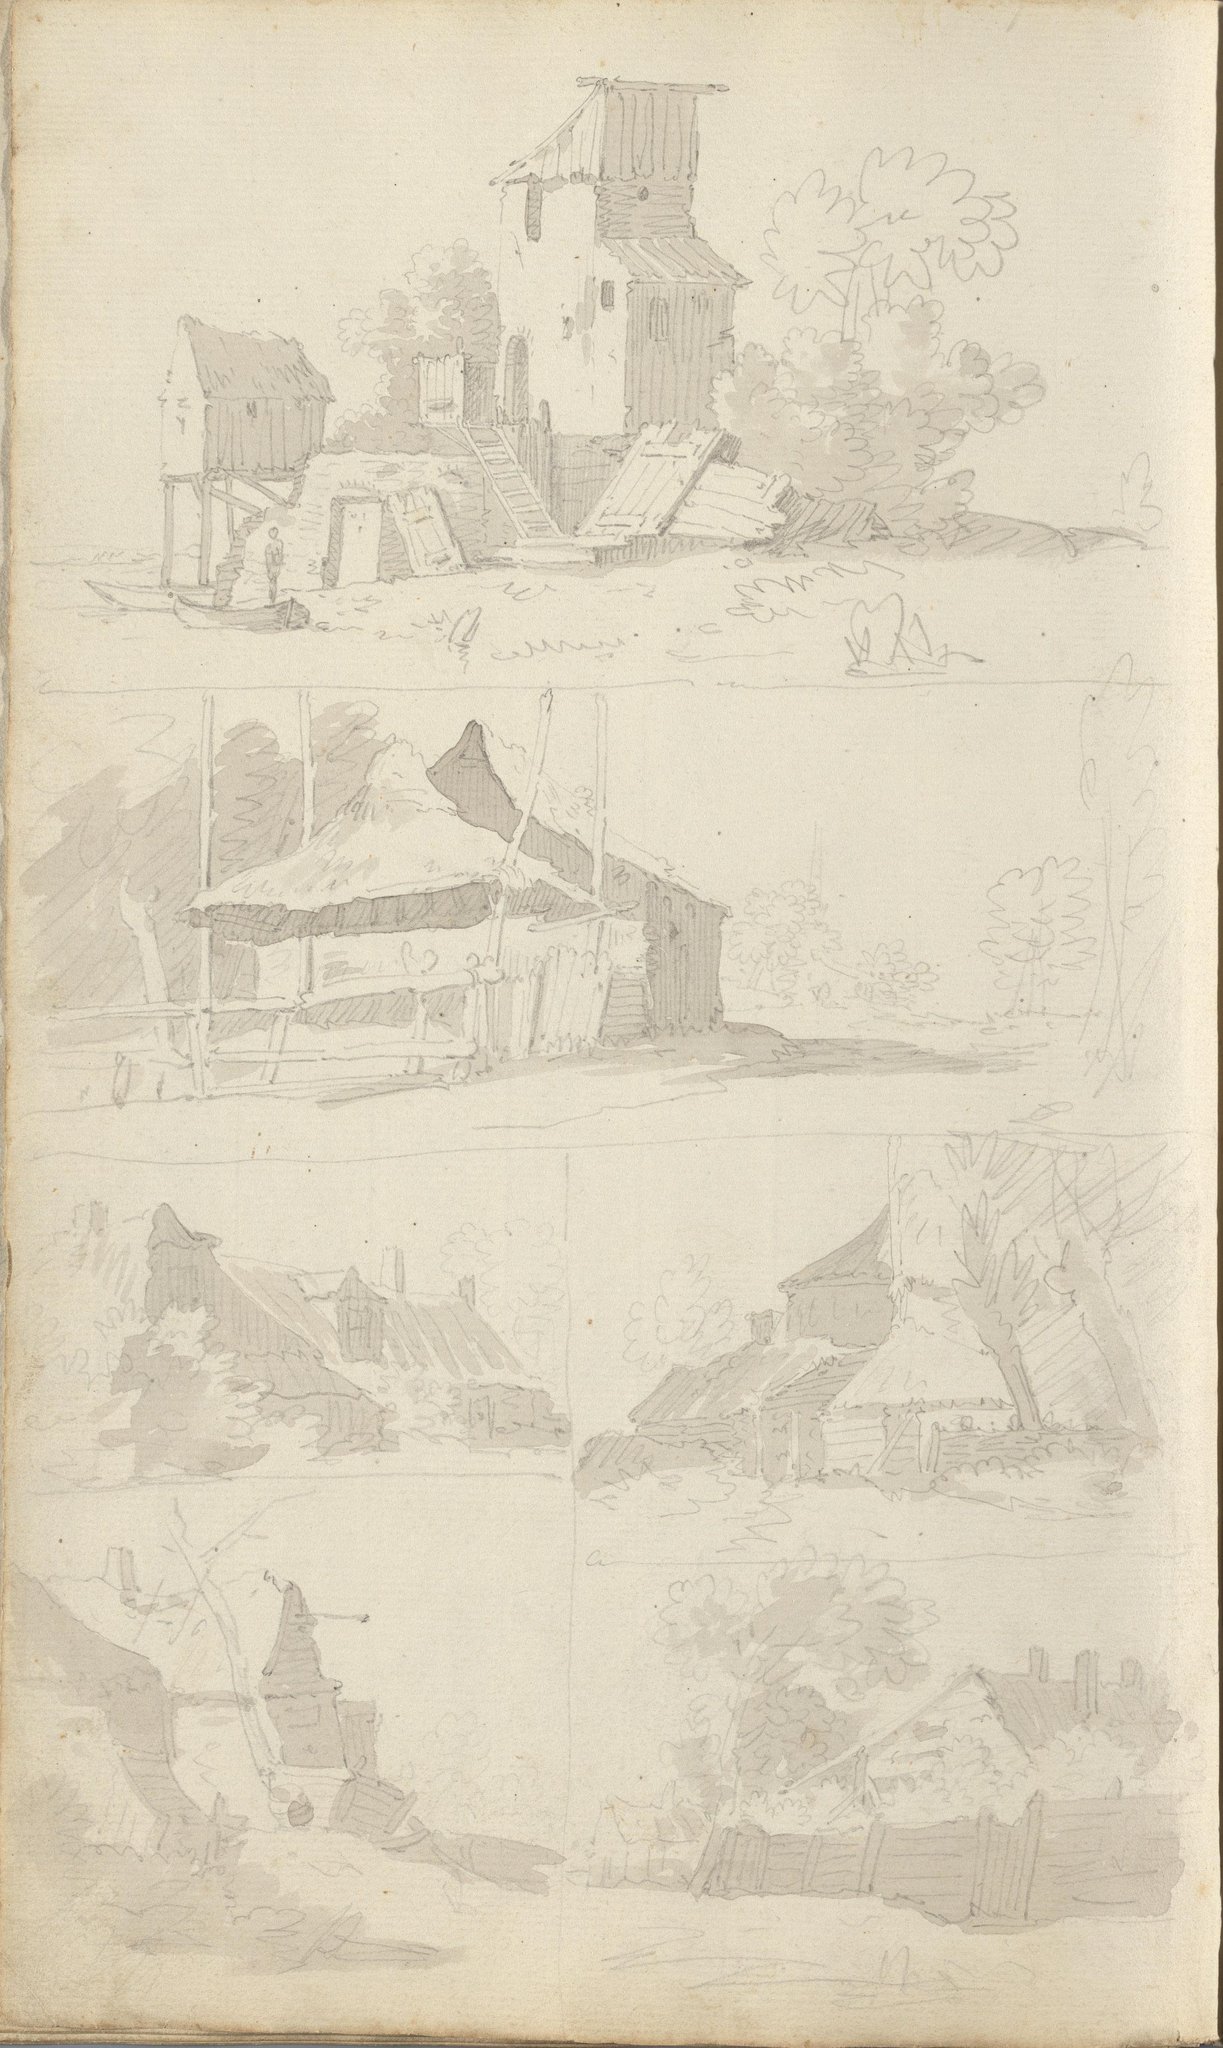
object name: sketchbook leaf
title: Boerderijen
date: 1780-1800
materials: ink, paper, pencil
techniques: brush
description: Blad 9 verso uit een schetsboek met 17 bladen.